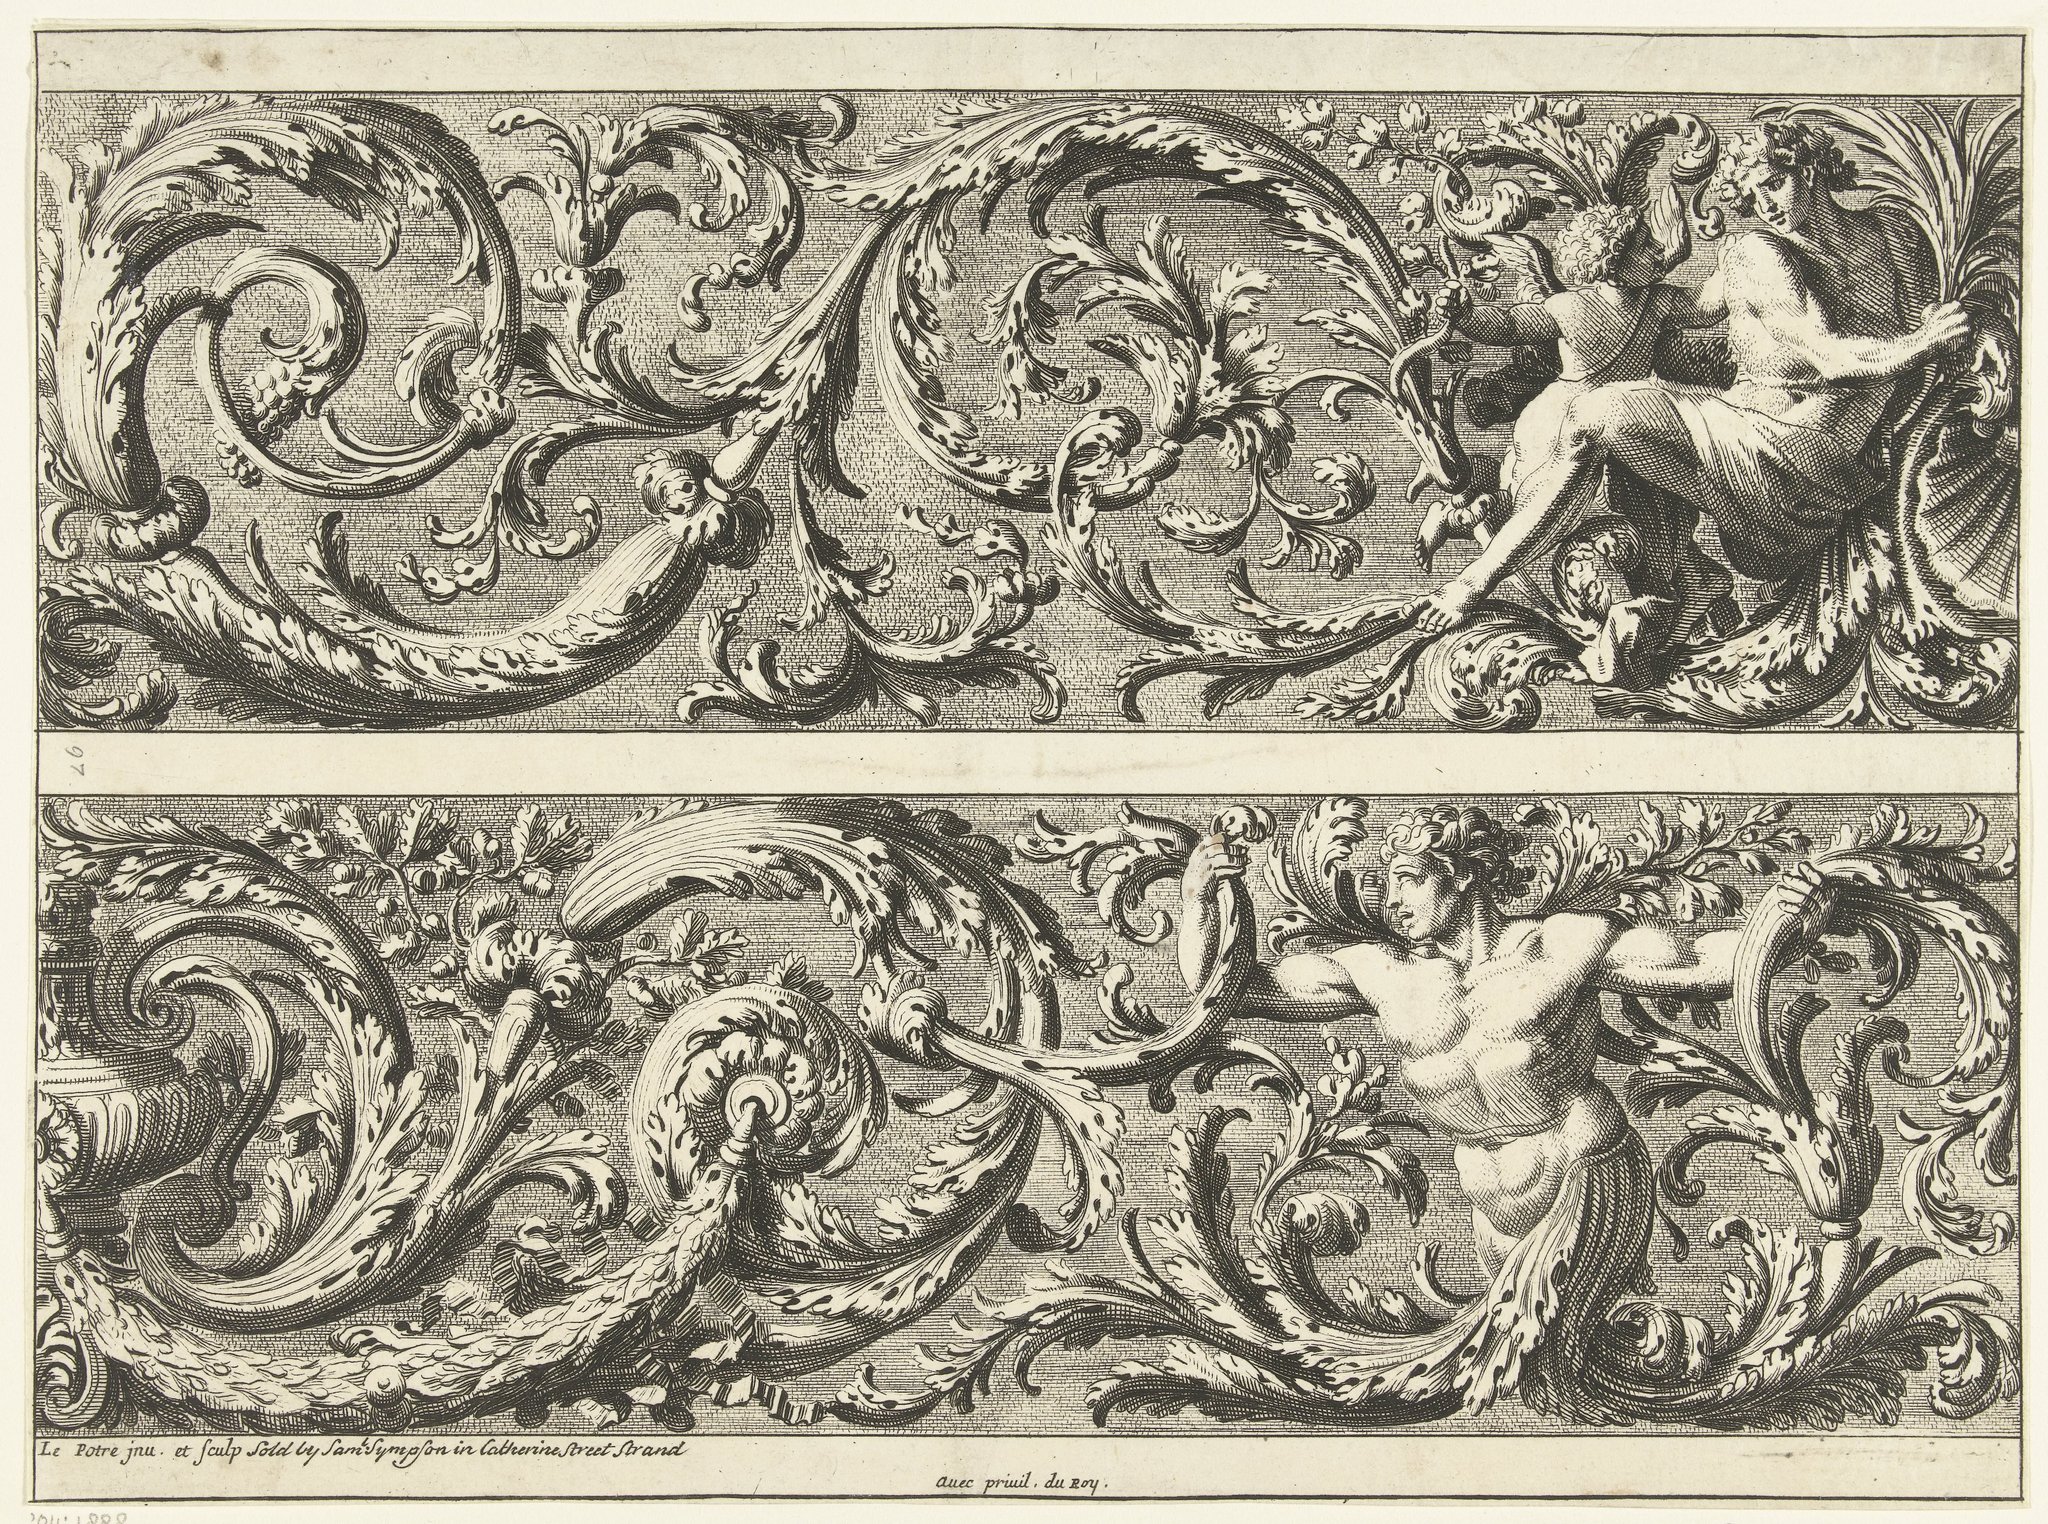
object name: print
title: Friezen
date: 1731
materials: paper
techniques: etching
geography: london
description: In het onderste fries staat links een halve urn en rechts een man wiens bovenlichaam ontspruit uit twee bladranken. Blad uit serie van 6, derde editie.